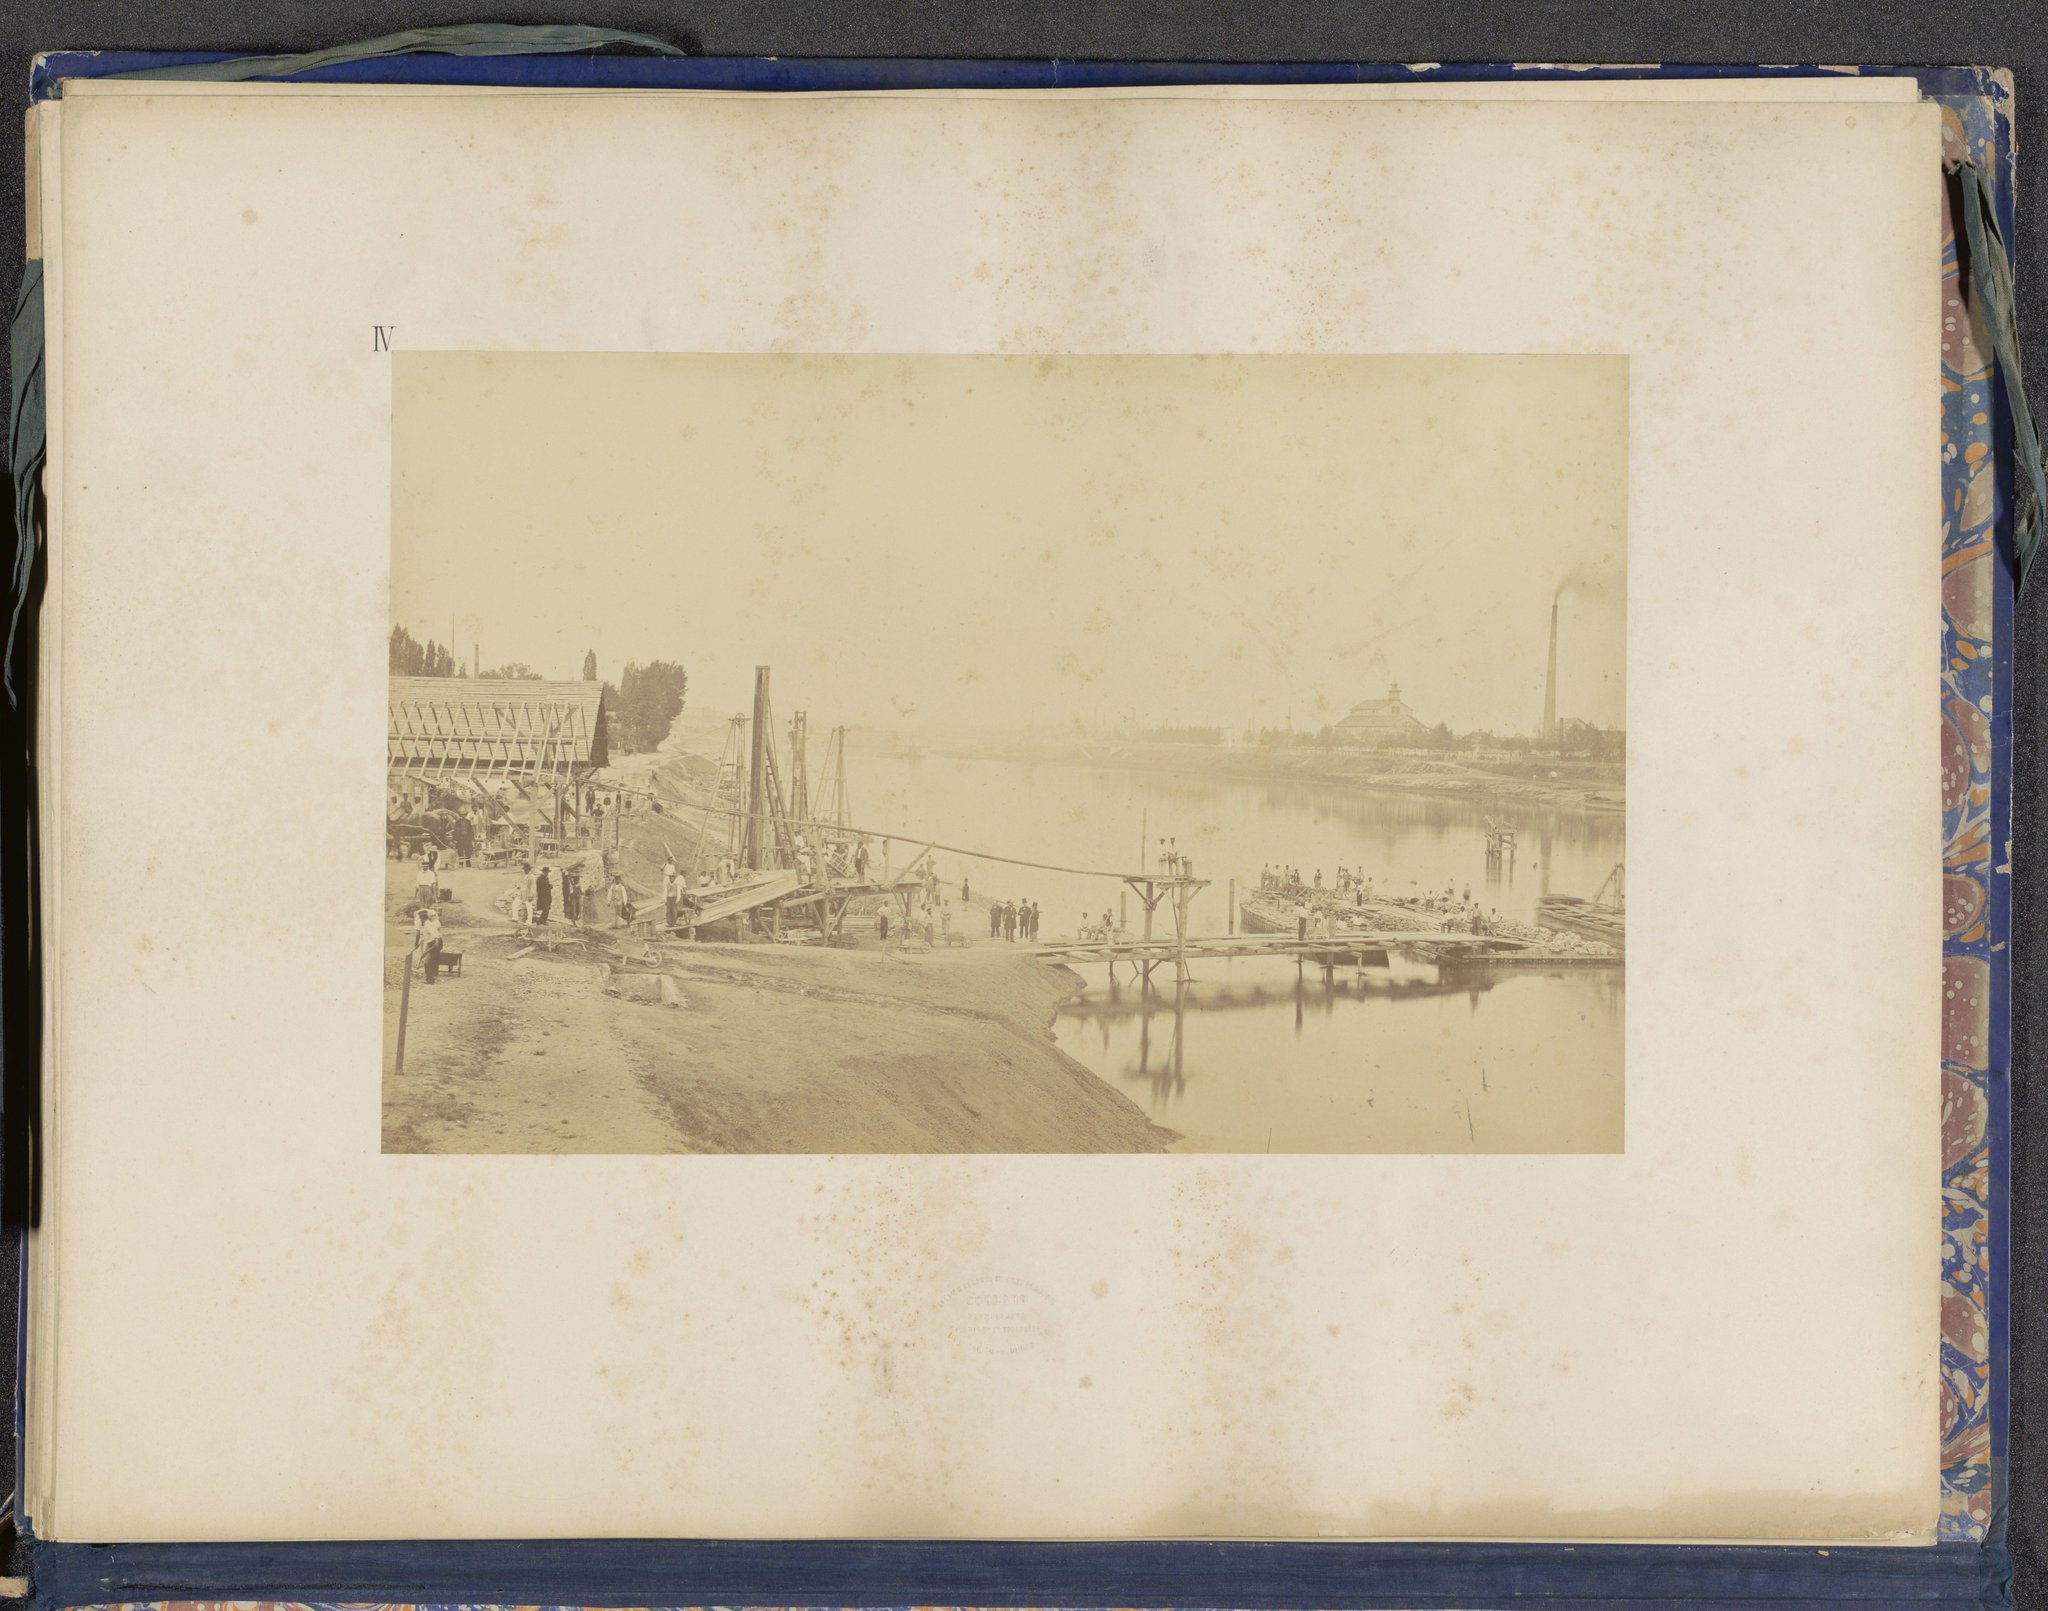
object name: photograph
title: Gezicht op een houten constructie voor de aanleg van het Viaduc d'Auteuil over de Seine bij Point-du-Jour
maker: auguste hippolyte collard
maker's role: fotograaf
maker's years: 1812-1887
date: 1863-1864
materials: photographic support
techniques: albumen print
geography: ile-de-france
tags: river, bridge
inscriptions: number: ‘IV’, name: ‘Atelier central de photographie Collard photographe des ponts et chaussées Bould. de Strasbourg, 39’